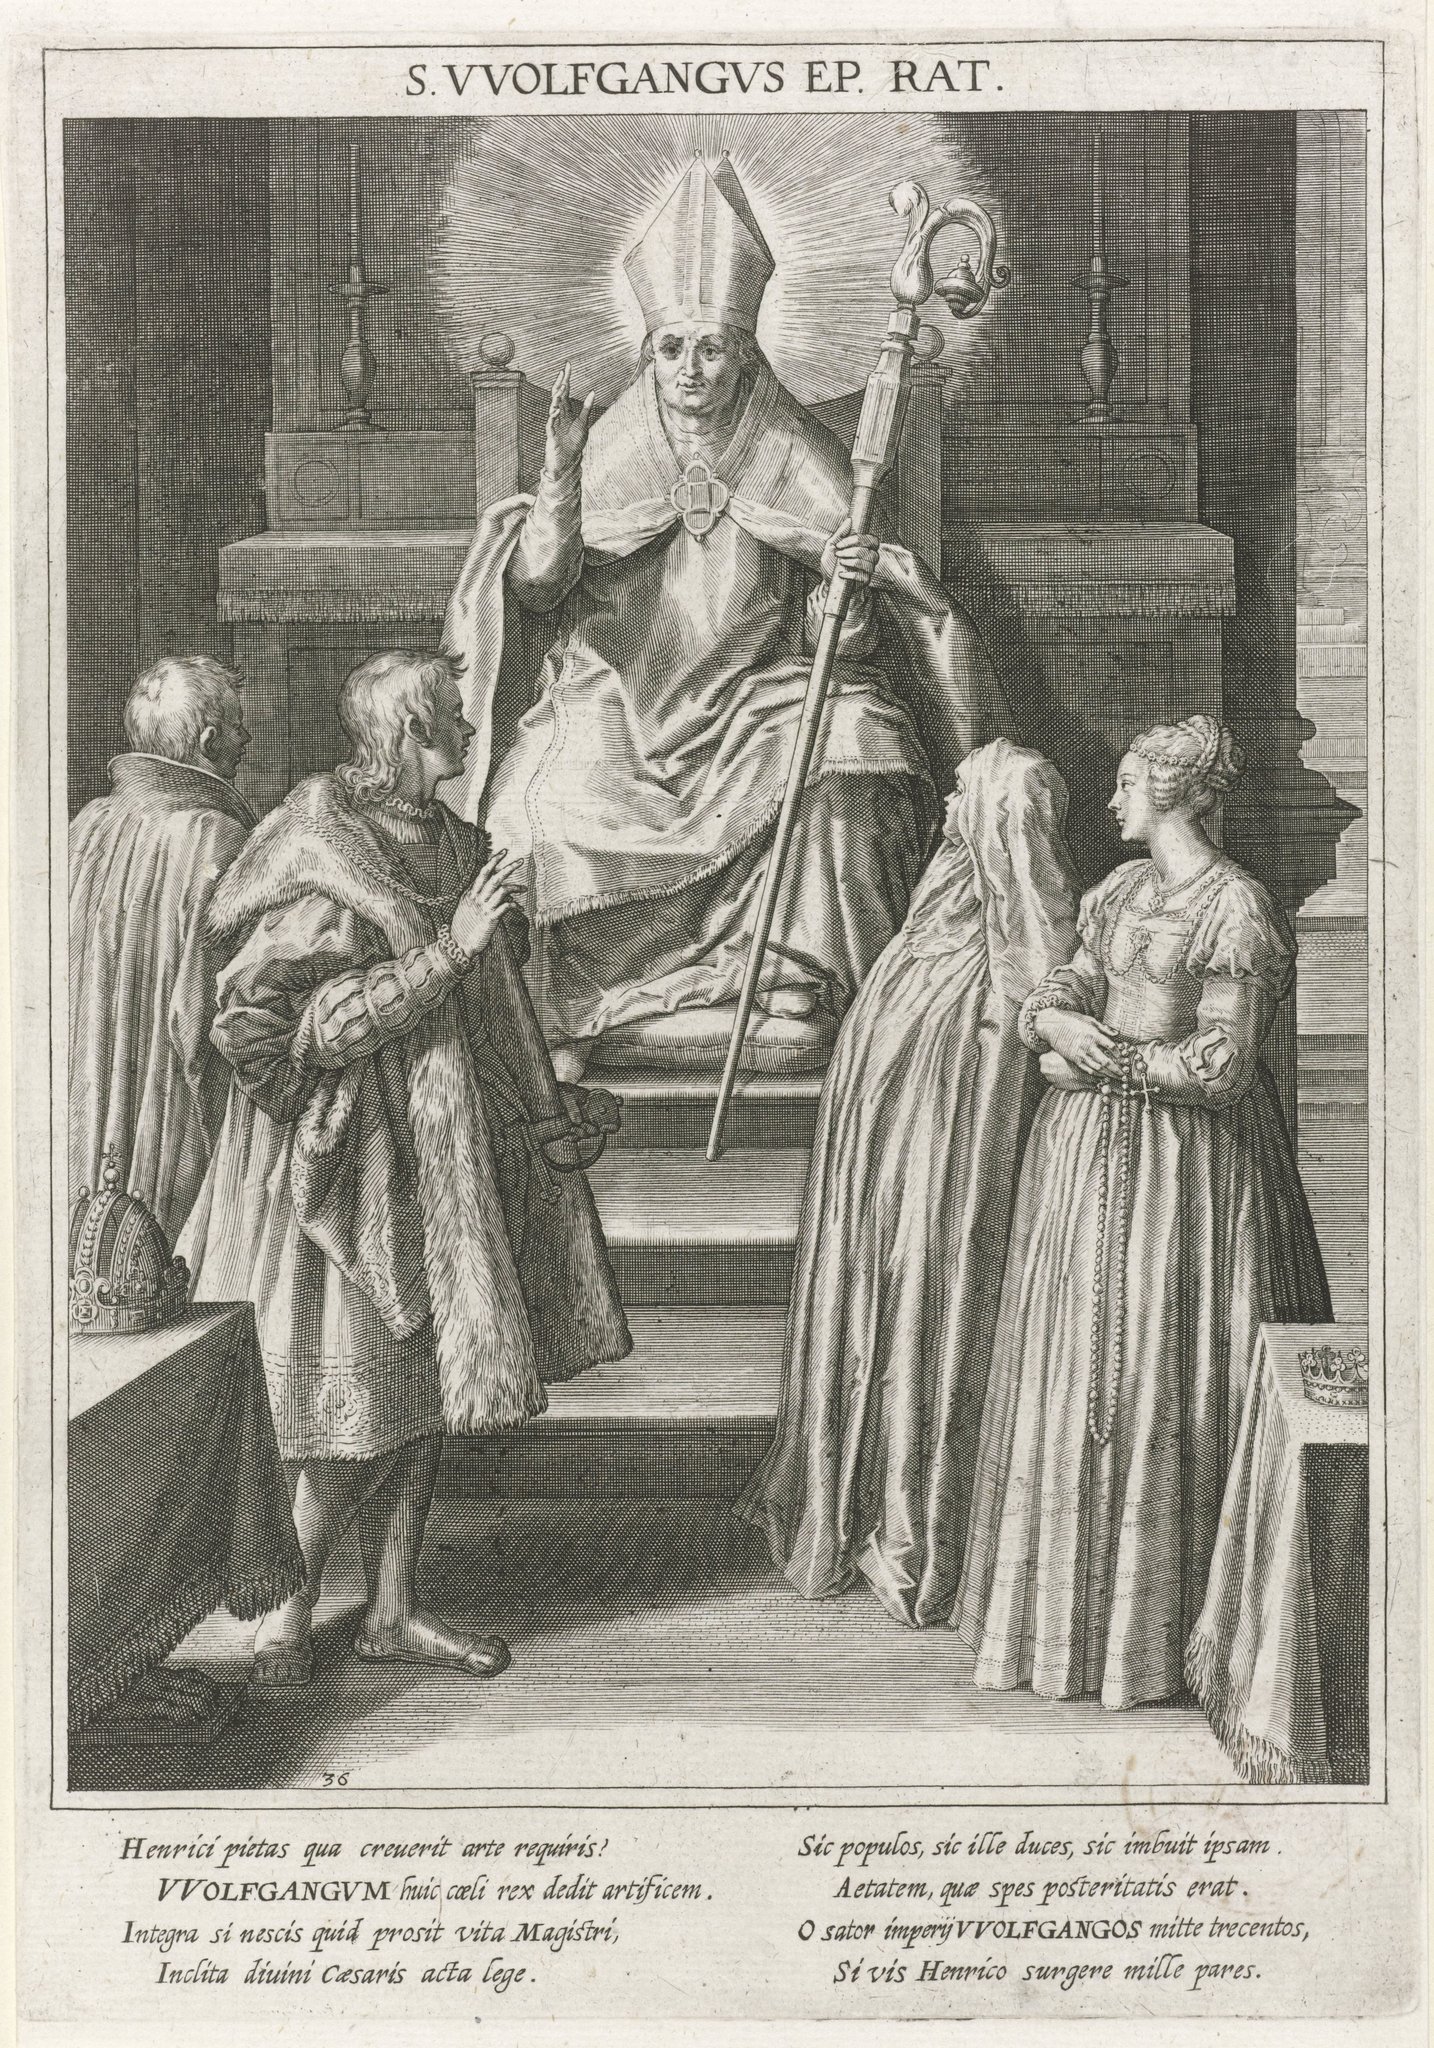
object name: print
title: Bavaria sancta I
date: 1615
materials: paper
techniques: engraving, etching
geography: munich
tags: male saints (with name), archbishop, bishop, etc. (roman catholic), education, nobility and patriciate; chivalry, knighthood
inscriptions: collector's mark: Lugt 240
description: H. Wolfgang, de bisschop van Regensburg, zit op een troon. Hij leert de kinderen van hertog Hendrik II van Beieren de beginselen van het christendom aan (onder hen Hendrik II, de latere keizer van het Heilig Roomse Rijk). De prent heeft een Latijns onderschrift en is de 36ste prent van een 60-delige serie met als onderwerp de heiligen van Beieren.